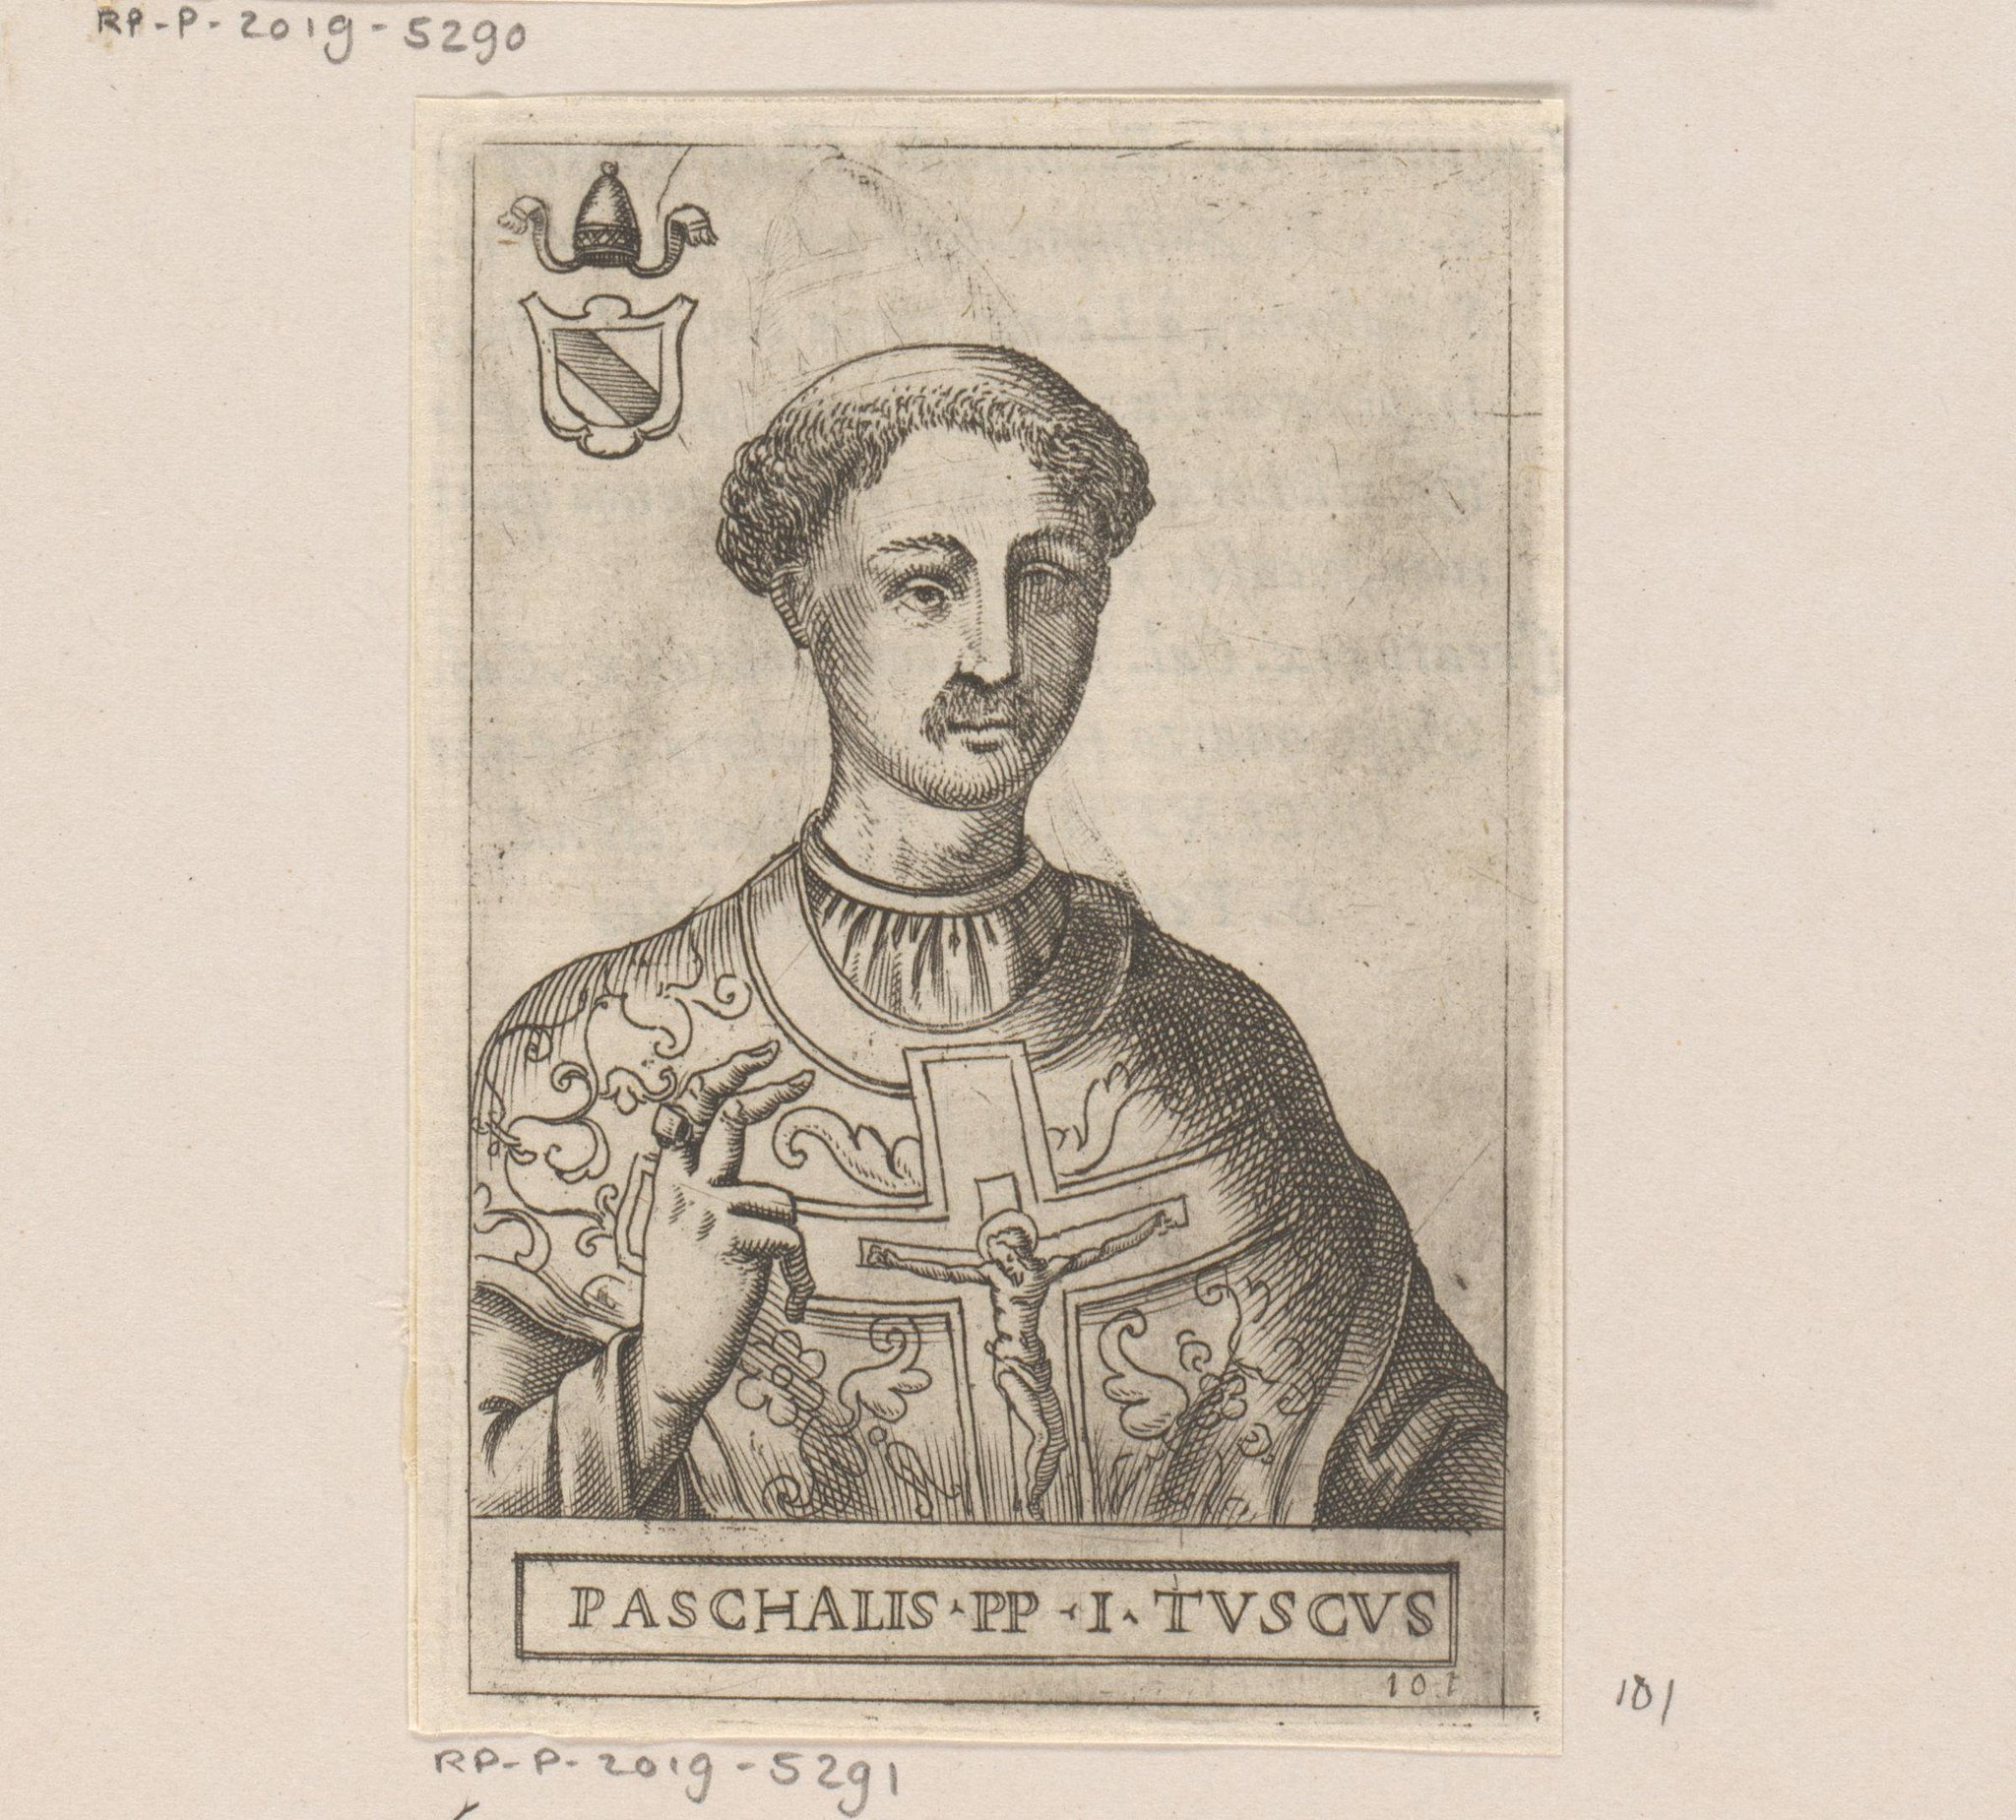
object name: print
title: Portret van paus Paschalis I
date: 1595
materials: paper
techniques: engraving, letterpress printing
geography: rome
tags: historical persons, pope, armorial bearing, heraldry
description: Prent uit: Cavalieri, Giovanni Battista de'. Effigies pontificum romanorum cum eorum vitis (...). Rome: Bartolomeo Bonfadino, 1595. Prent voor het eerst verschenen in: Cavalieri, Giovanni Battista de'. Pontificum romanorum effigies (...). Rome: Domenico Basa en Francesco Zanetti, 1580. Prent ook gebruikt in latere publicaties.